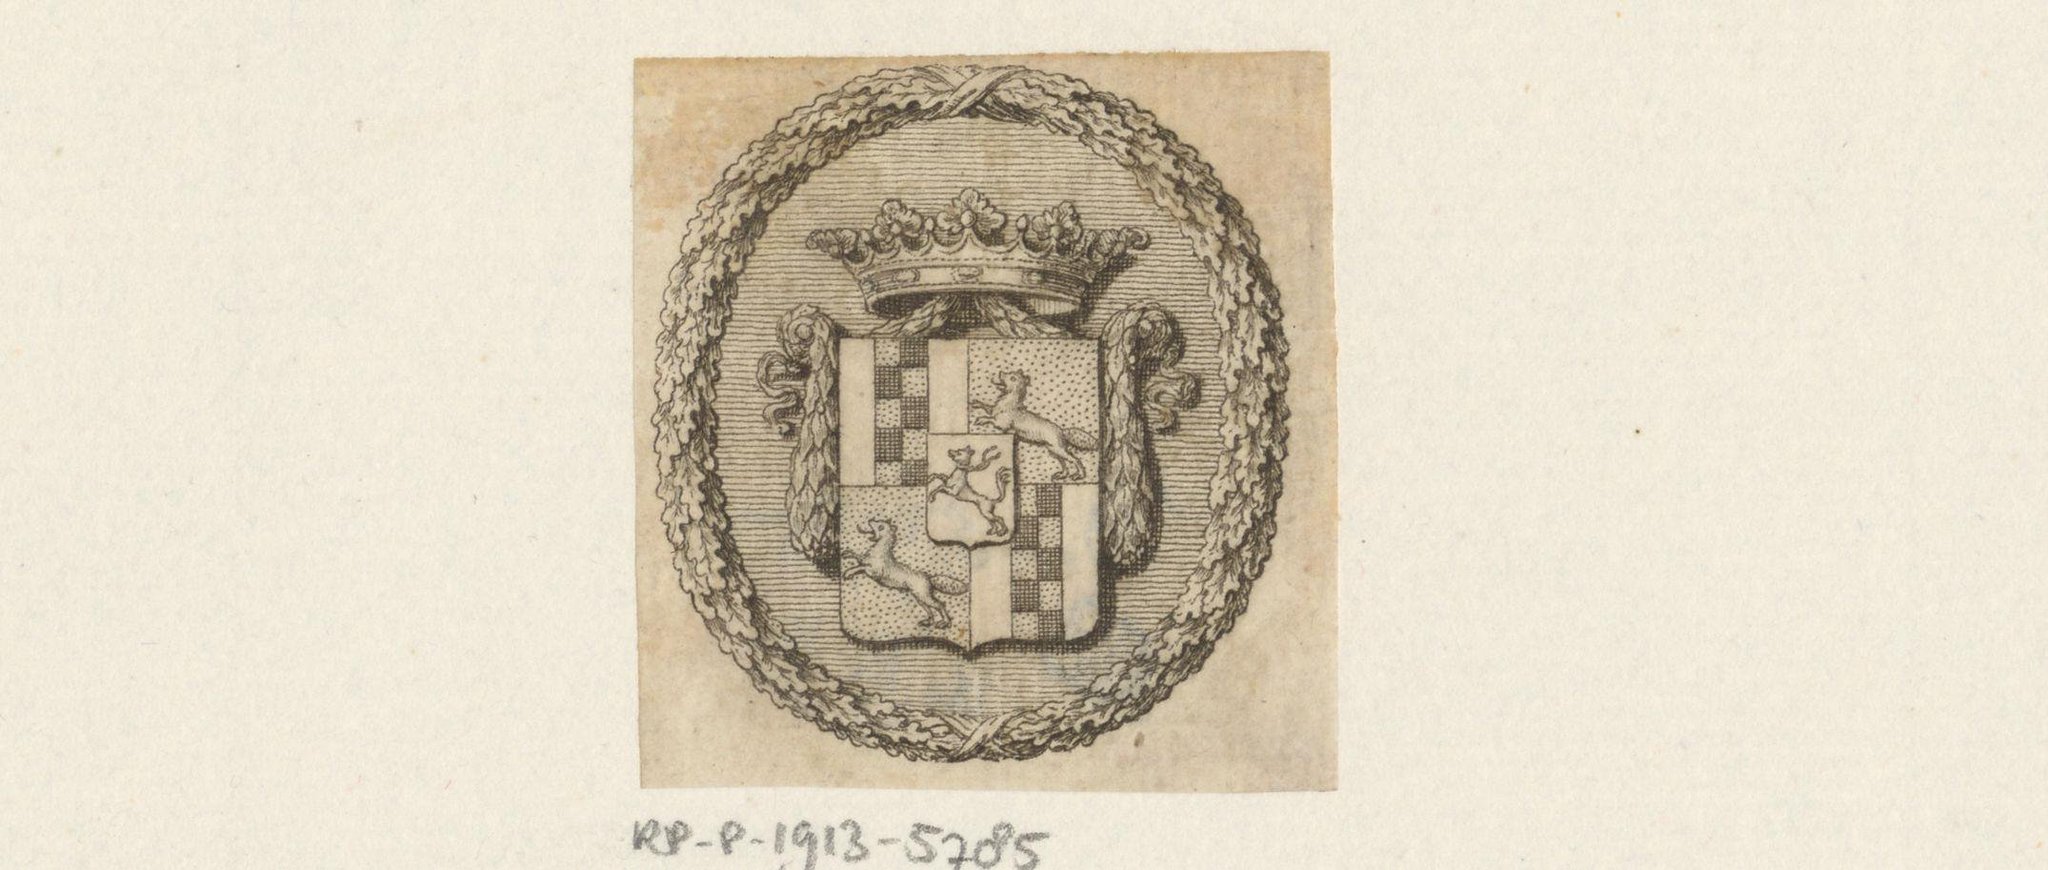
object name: bookplate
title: Ex libris van onbekend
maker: Anonymous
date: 1750-1900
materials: paper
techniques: etching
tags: garland, wreath, armorial bearing, heraldry, beasts of prey, predatory animals: fox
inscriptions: collector's mark: Lugt 2760, collector's mark: Lugt 2233